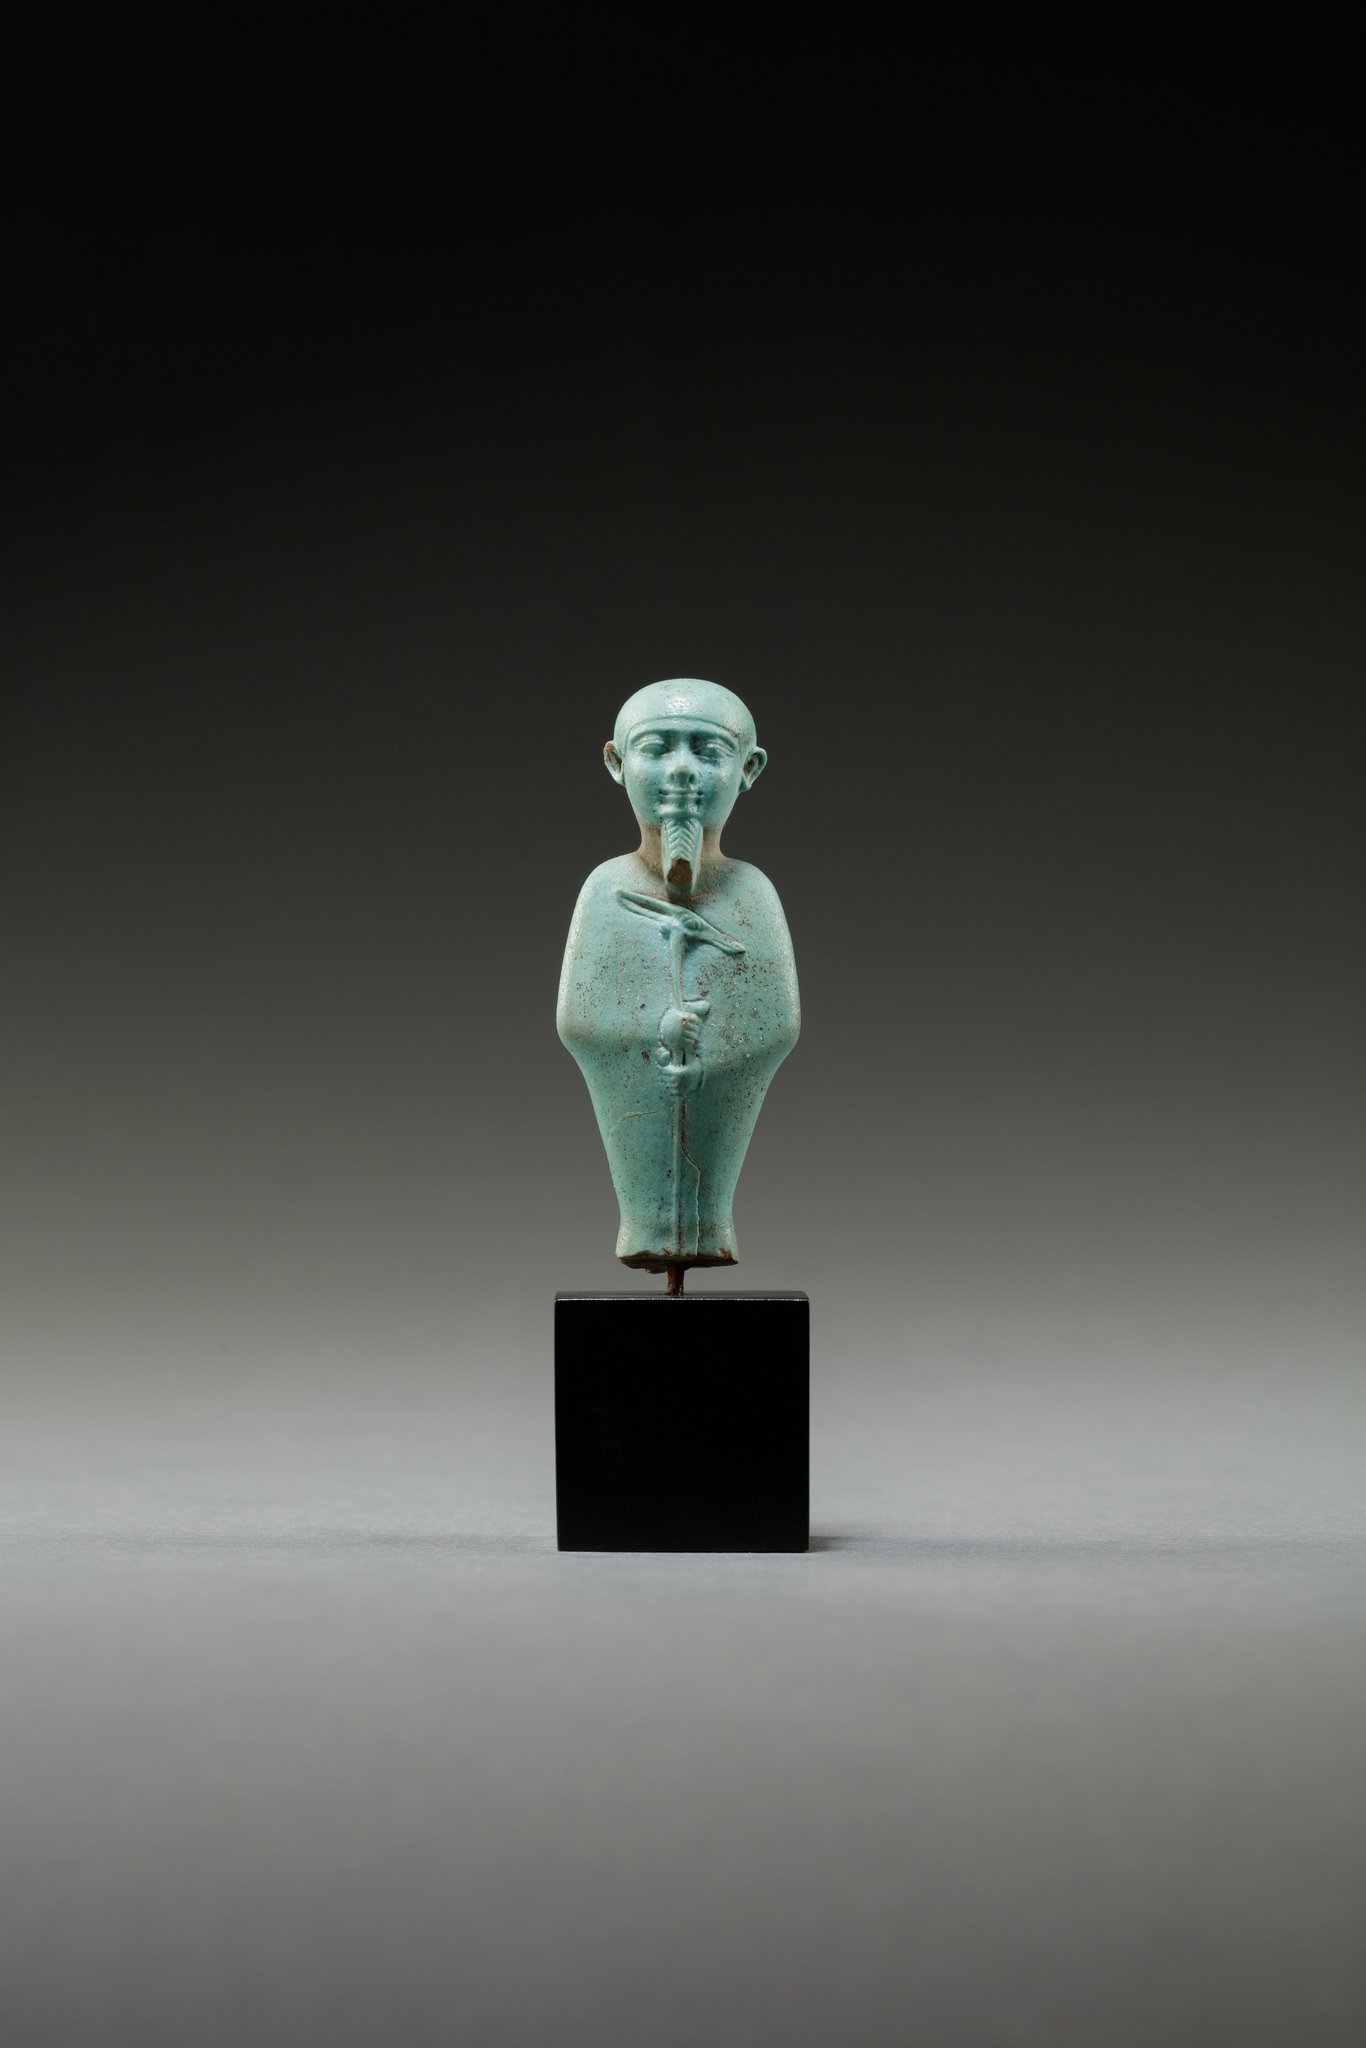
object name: ptah figure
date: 730-332 BCE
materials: faience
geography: egypt